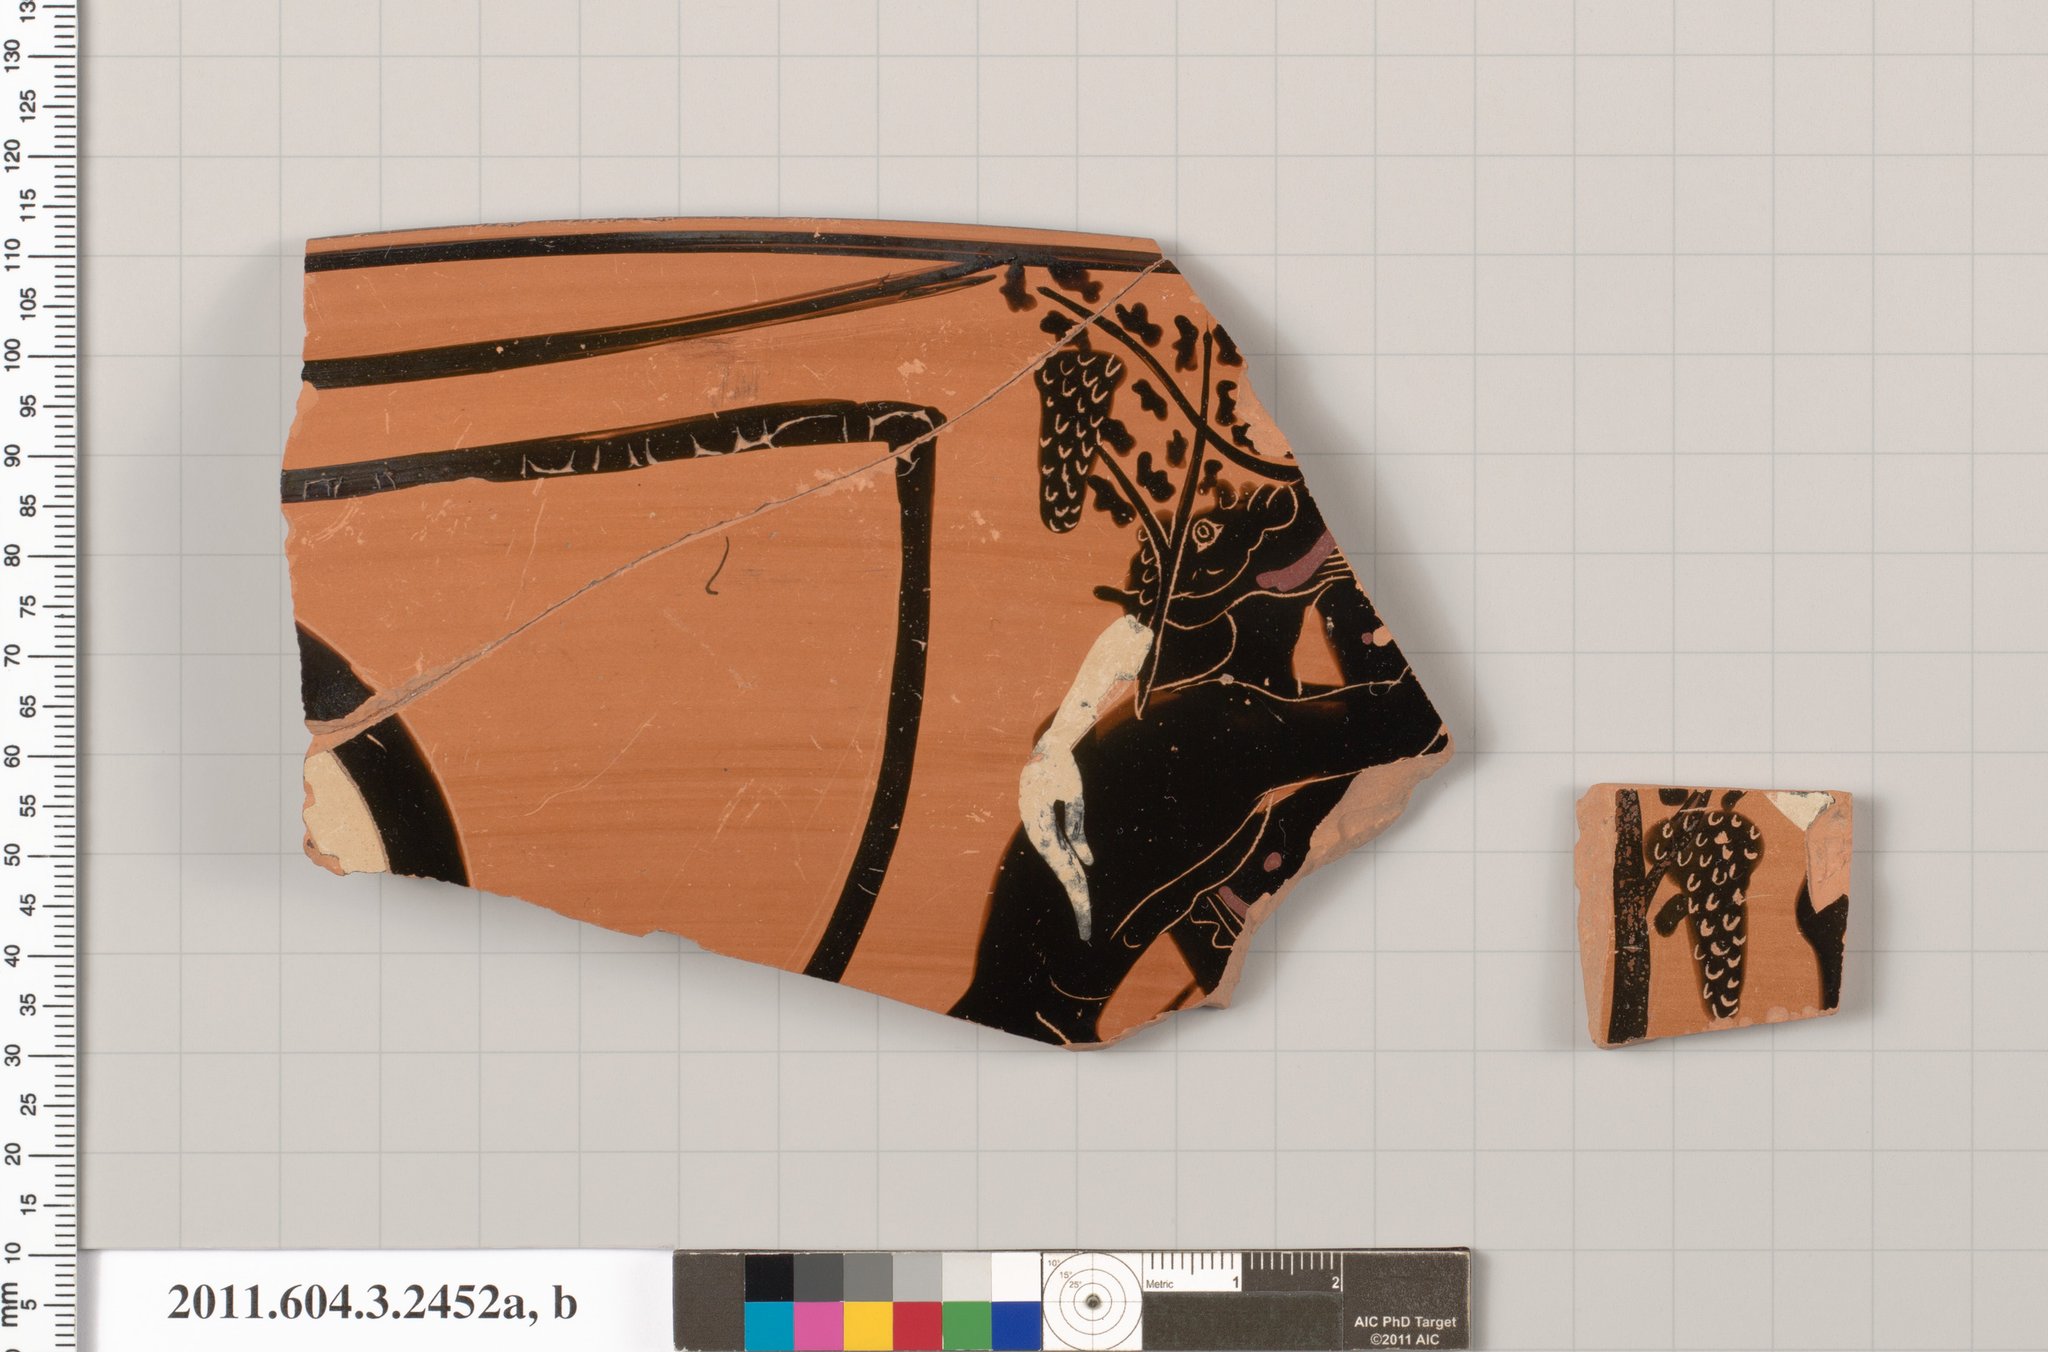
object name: kylix fragment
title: Terracotta fragments of a kylix: eye-cup (drinking cup)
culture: greek, attic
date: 530-510 BCE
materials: terracotta